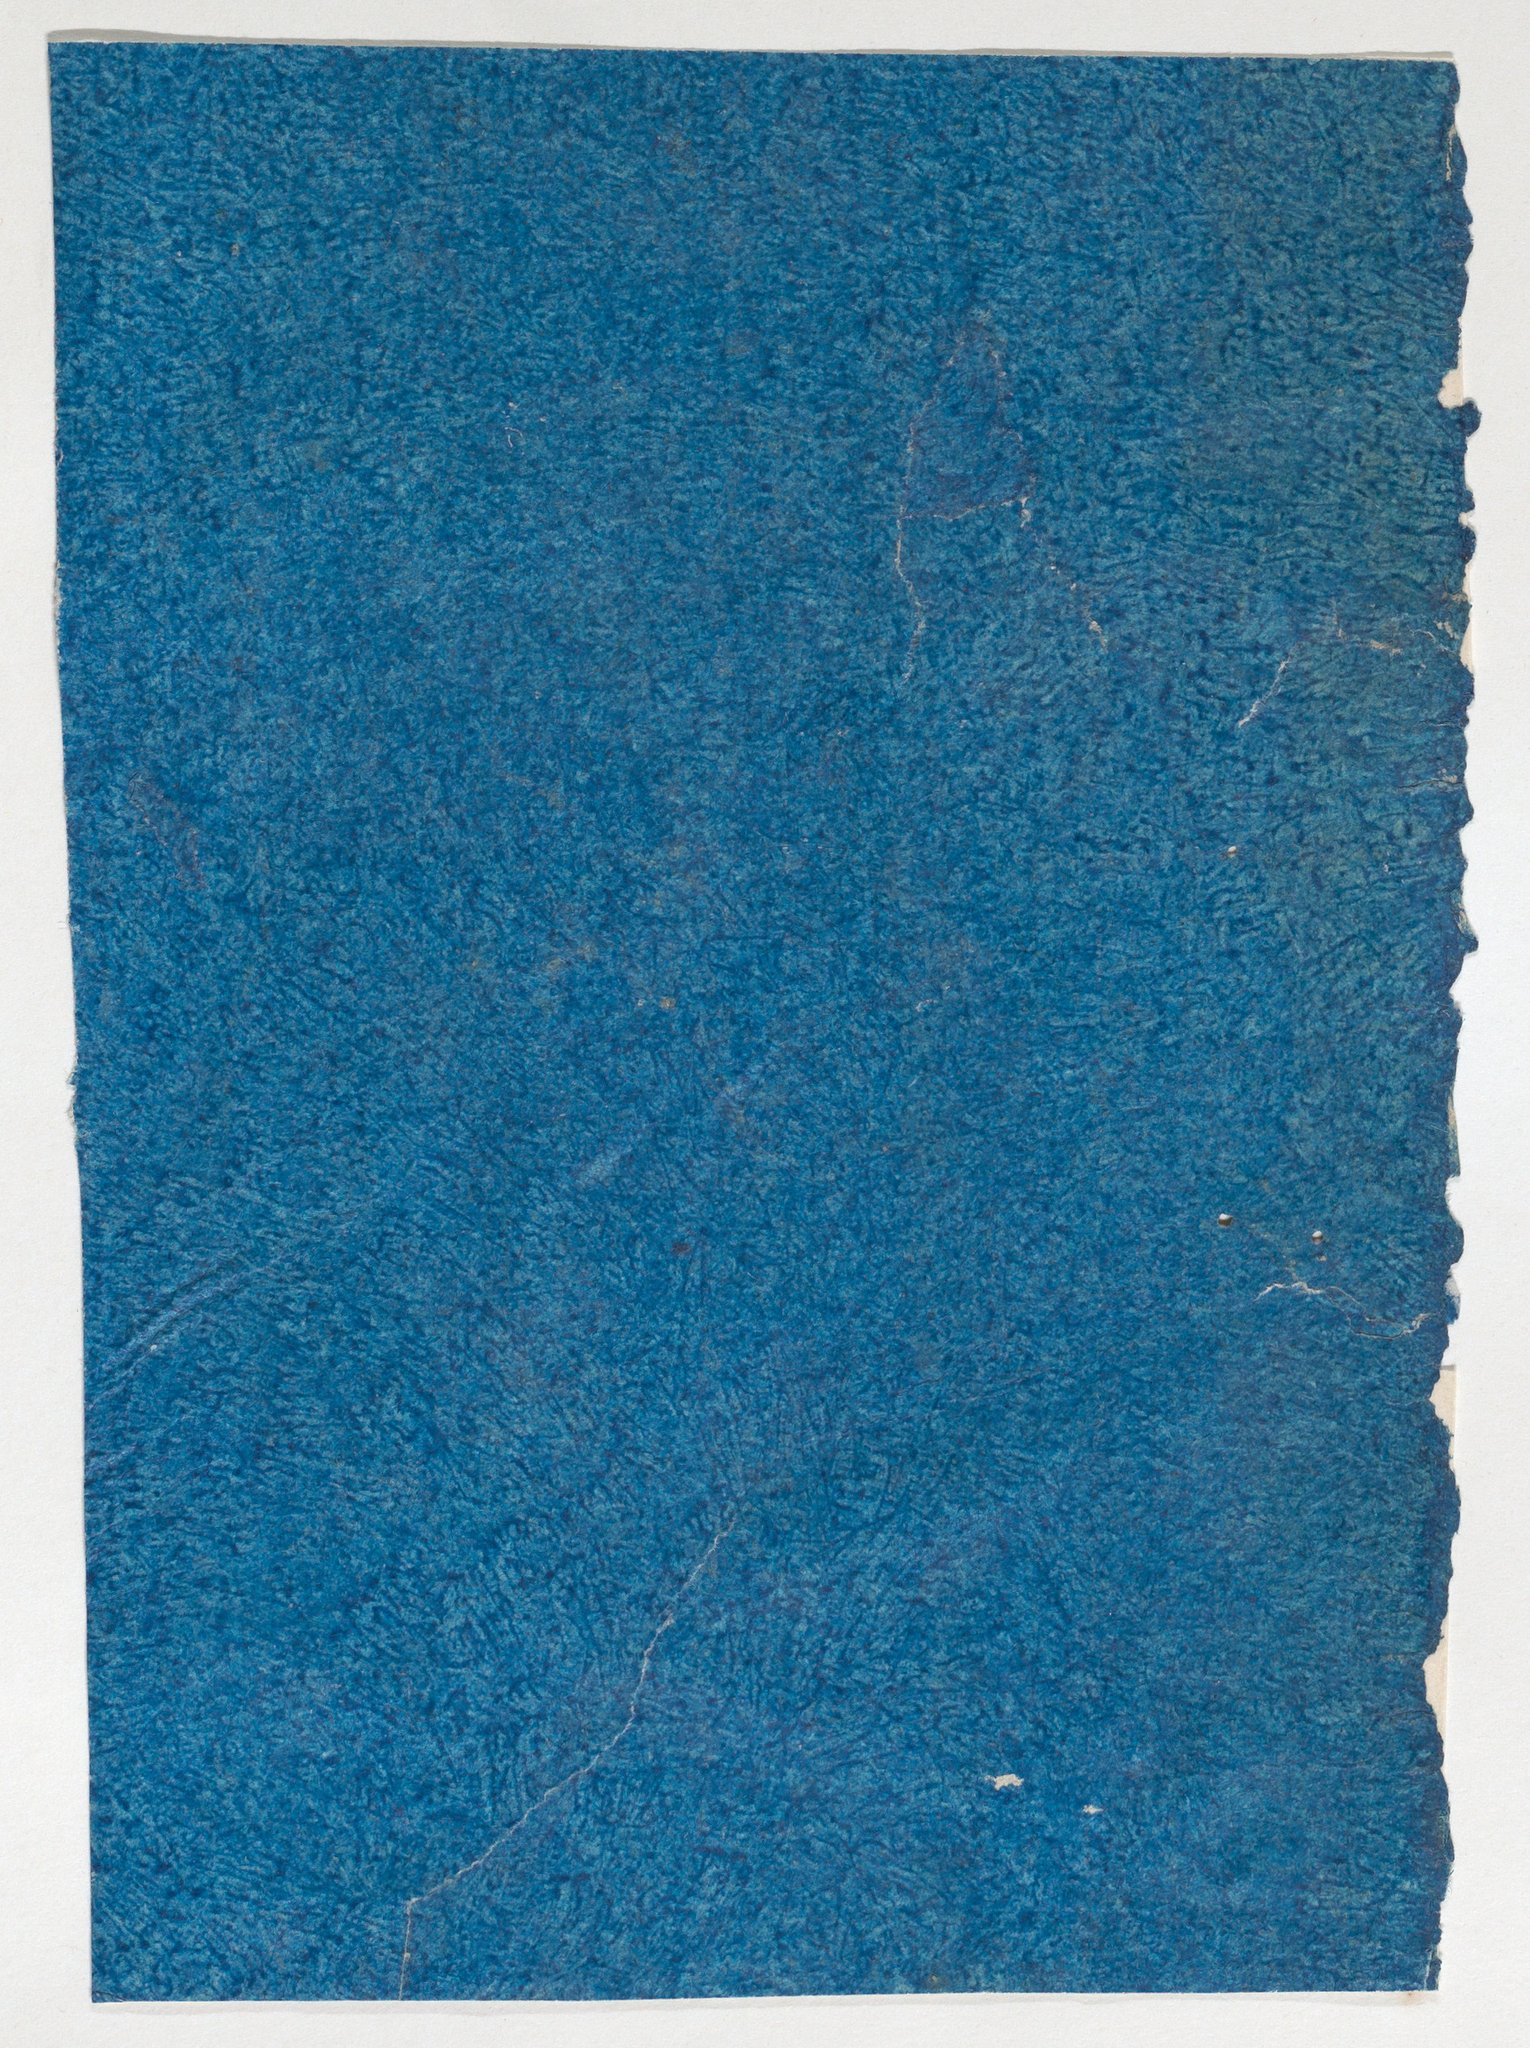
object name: print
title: Blue paste paper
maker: Anonymous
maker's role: artist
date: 1701-1800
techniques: relief print